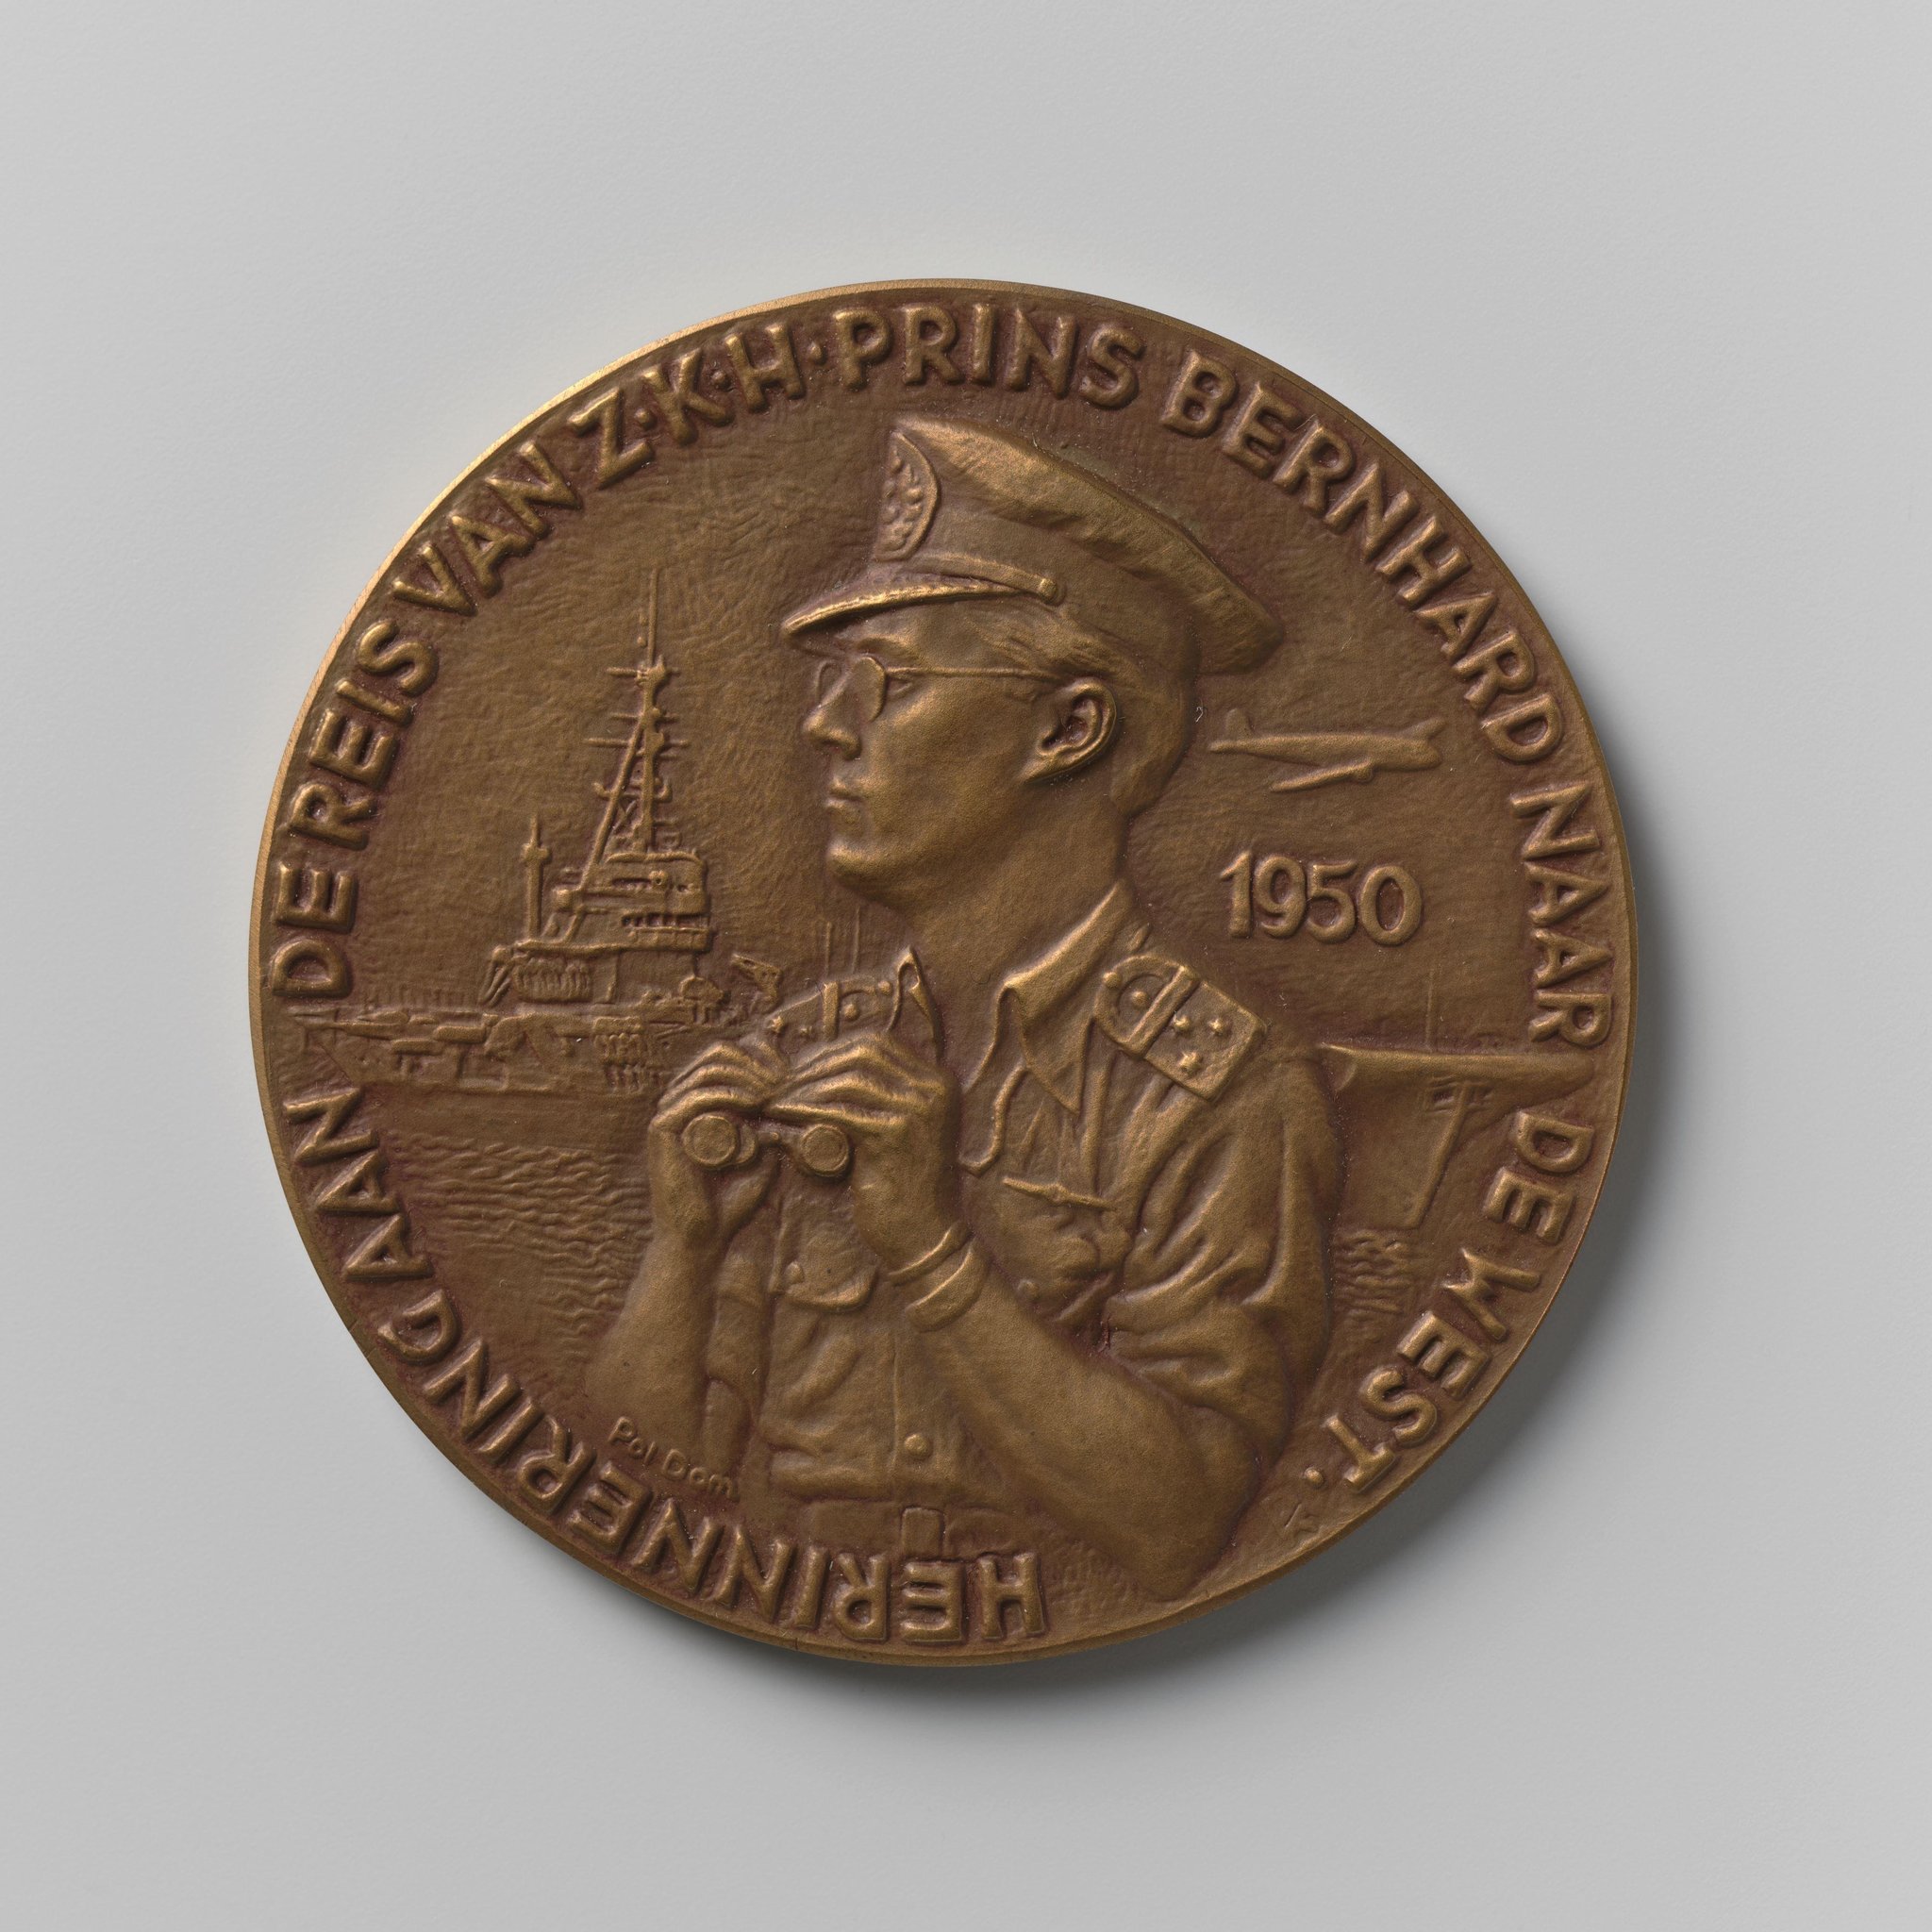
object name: history medal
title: Reis van prins Bernhard naar West-Indië (Vereniging voor Penningkunst 1950, eerste penning)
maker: pol dom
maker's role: painter, print maker, sculptor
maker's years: 1885-1978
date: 1950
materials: bronze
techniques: striking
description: Bronzen penning, op de voorzijde Bernhard half naar links met verrekijker, op de achtergrond een oorlogsschip, met omschrift, op de achtergrond tien regels tekst.